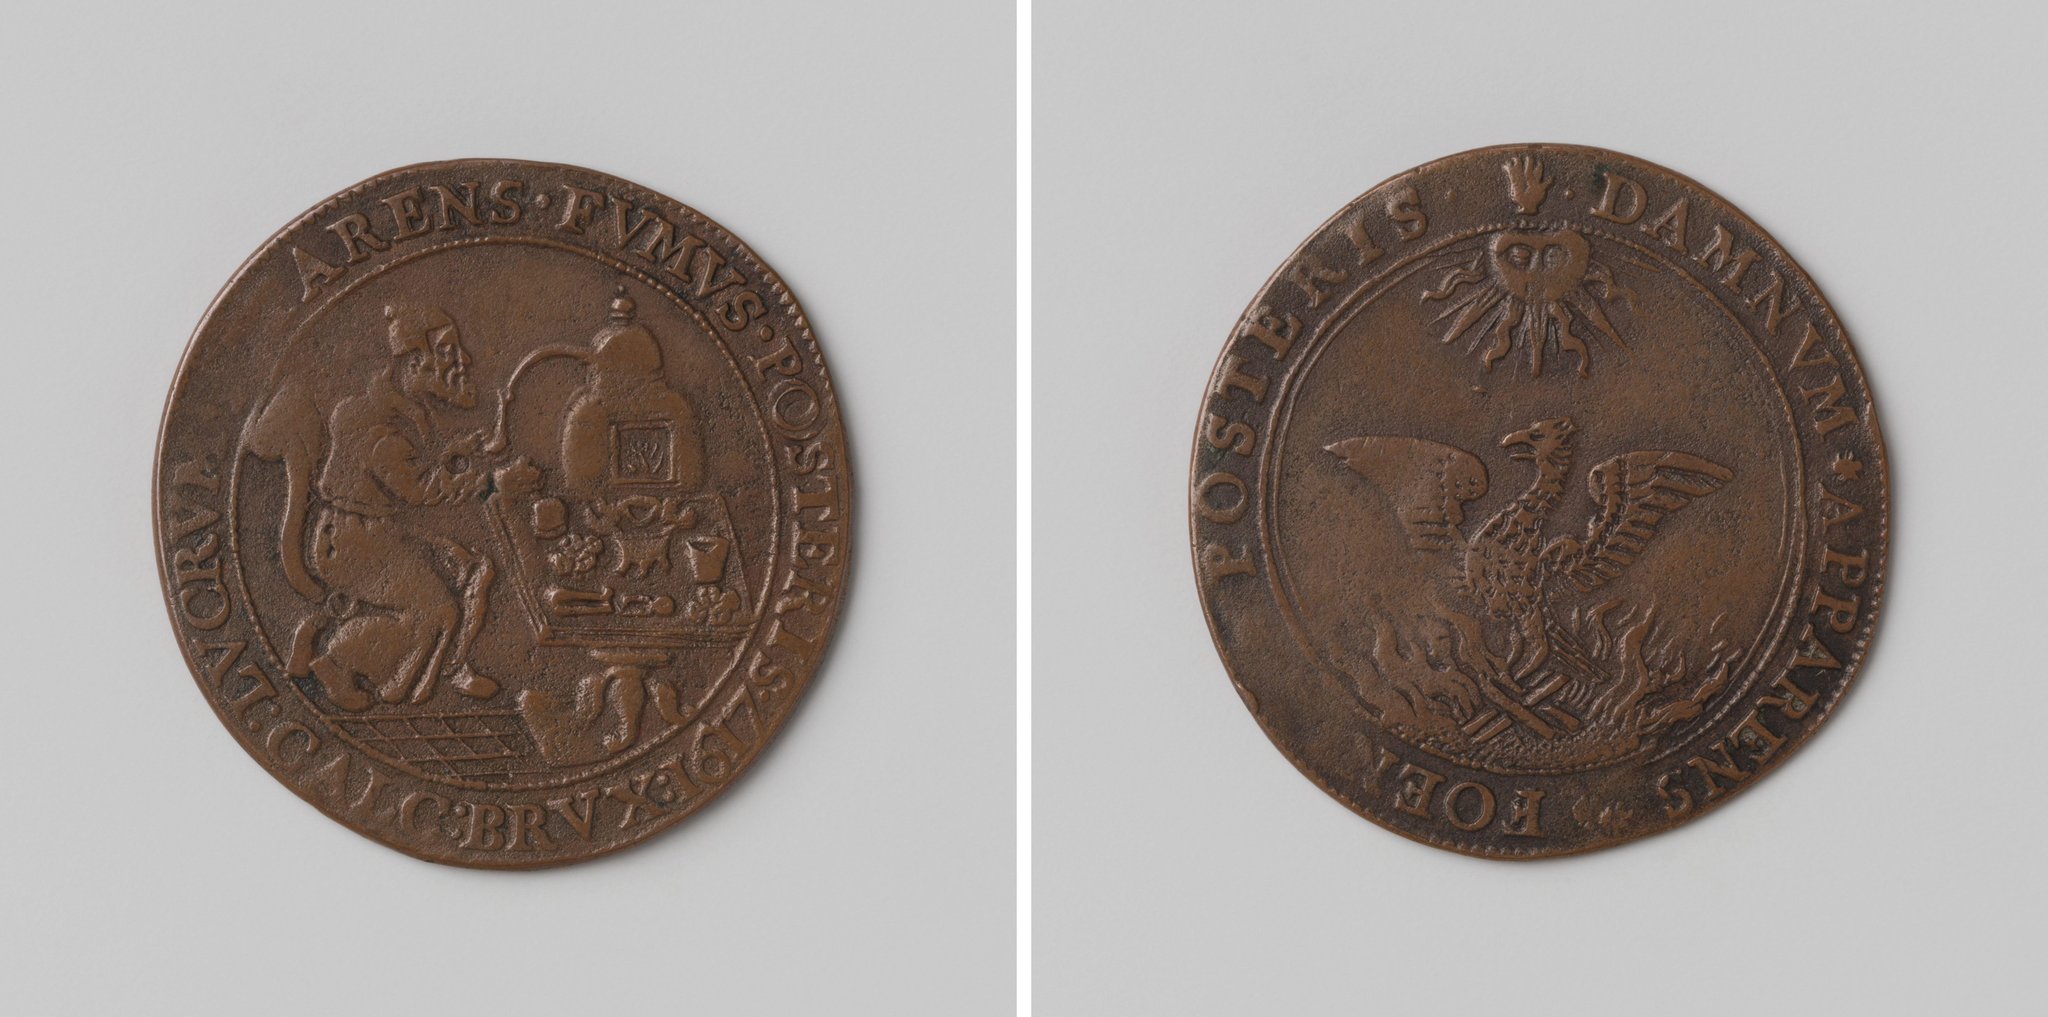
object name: jeton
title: Stad Brussel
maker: Anonymous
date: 1617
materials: copper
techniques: striking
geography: antwerp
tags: brussels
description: Koperen penning. Voorzijde: man, zittend aan tafel, waarop allerlei instrumenten liggen; naast hem oven binnen omschrift. Keerzijde: beschenen door hemellicht herrijst phoenix uit vlammen binnen omschrift